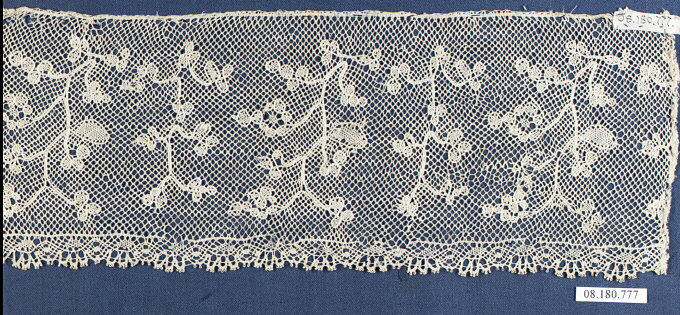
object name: border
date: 1701-1800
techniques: lace